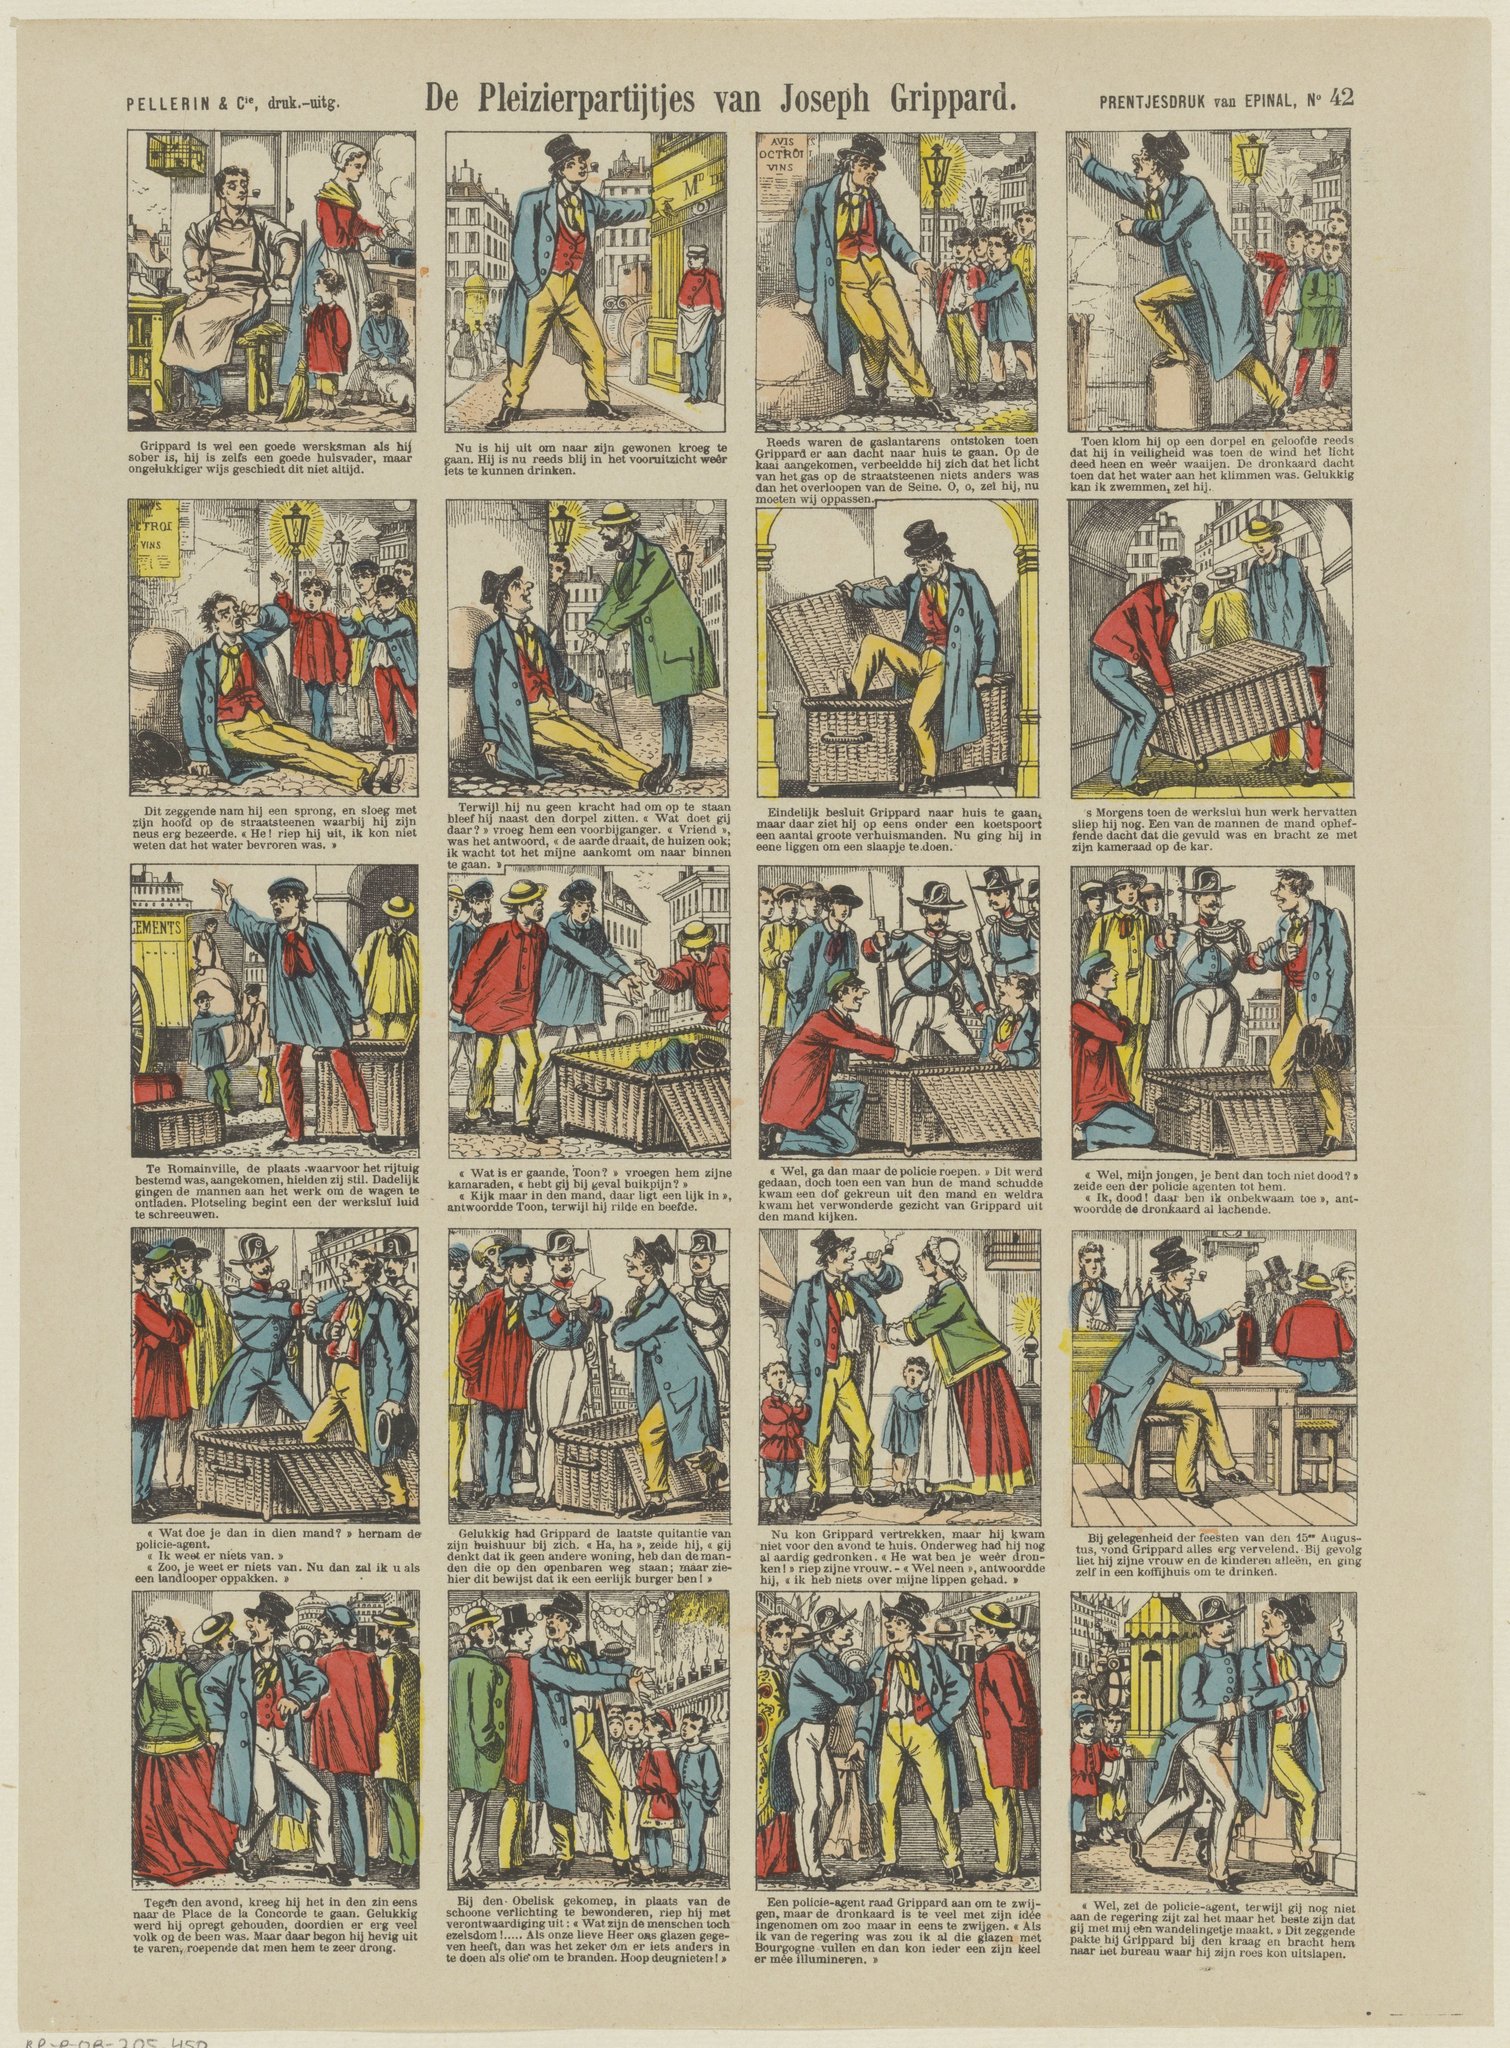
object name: print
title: Prentjesdruk van Épinal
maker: Anonymous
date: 1902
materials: paper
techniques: colour, letterpress printing, lithograph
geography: epinal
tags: drunkard, drunkenness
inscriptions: collector's mark: Lugt 2760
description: Blad met 20 voorstellingen over de dronken Joseph Grippard. Onder elke afbeelding een onderschrift. Genummerd rechtsboven: No 42.